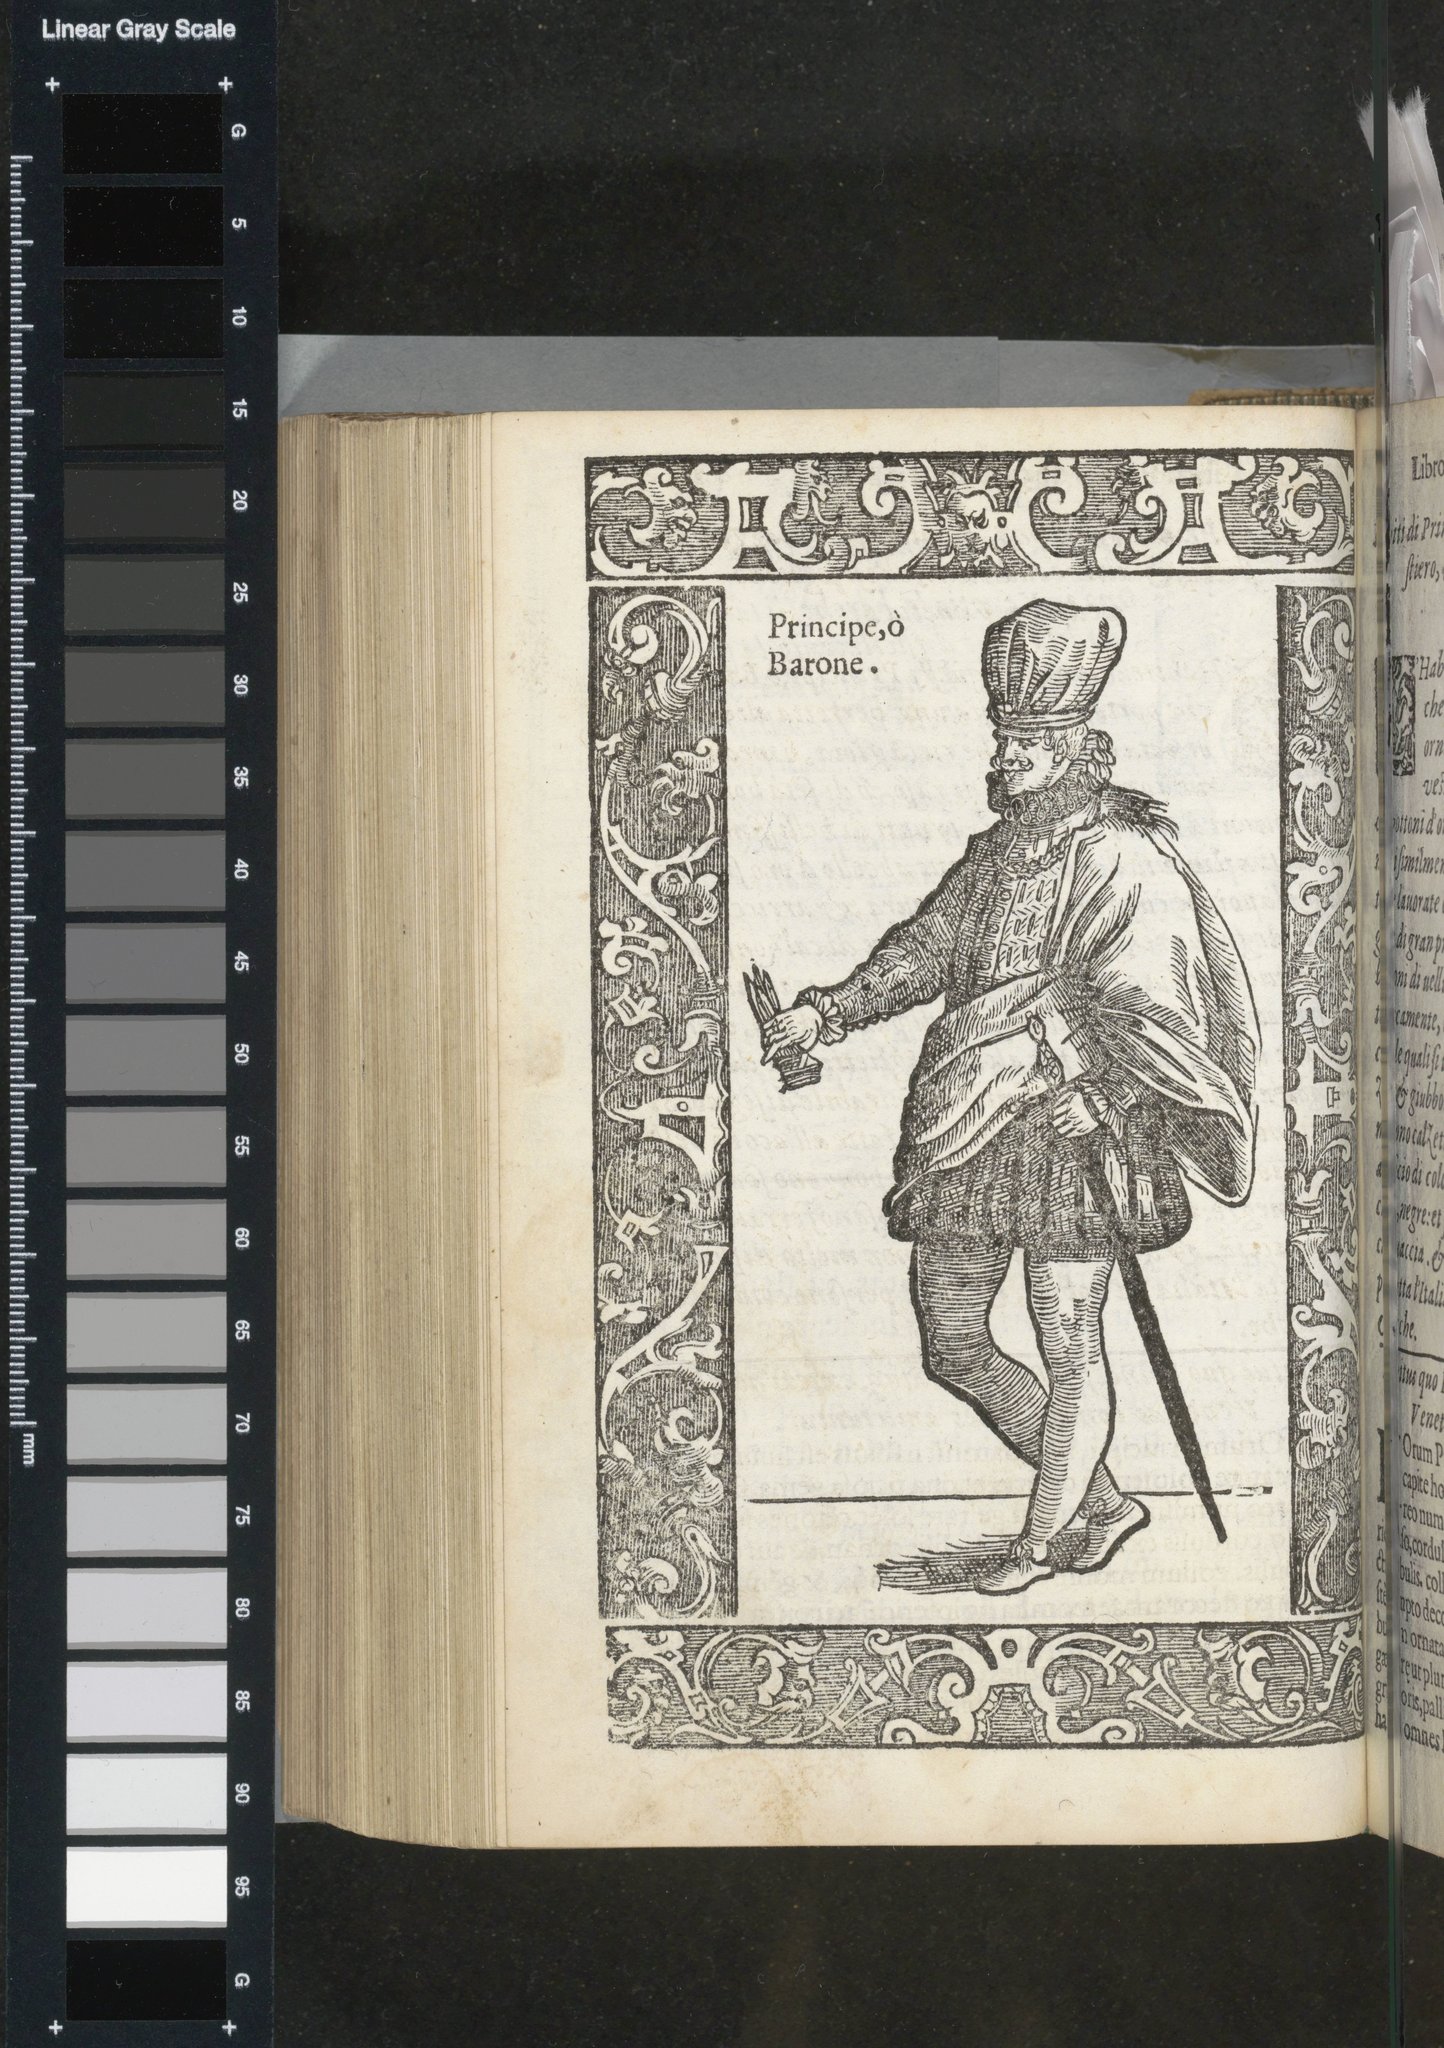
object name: costume print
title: Principe, o barone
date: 1598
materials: paper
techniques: woodcut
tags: fashion plates